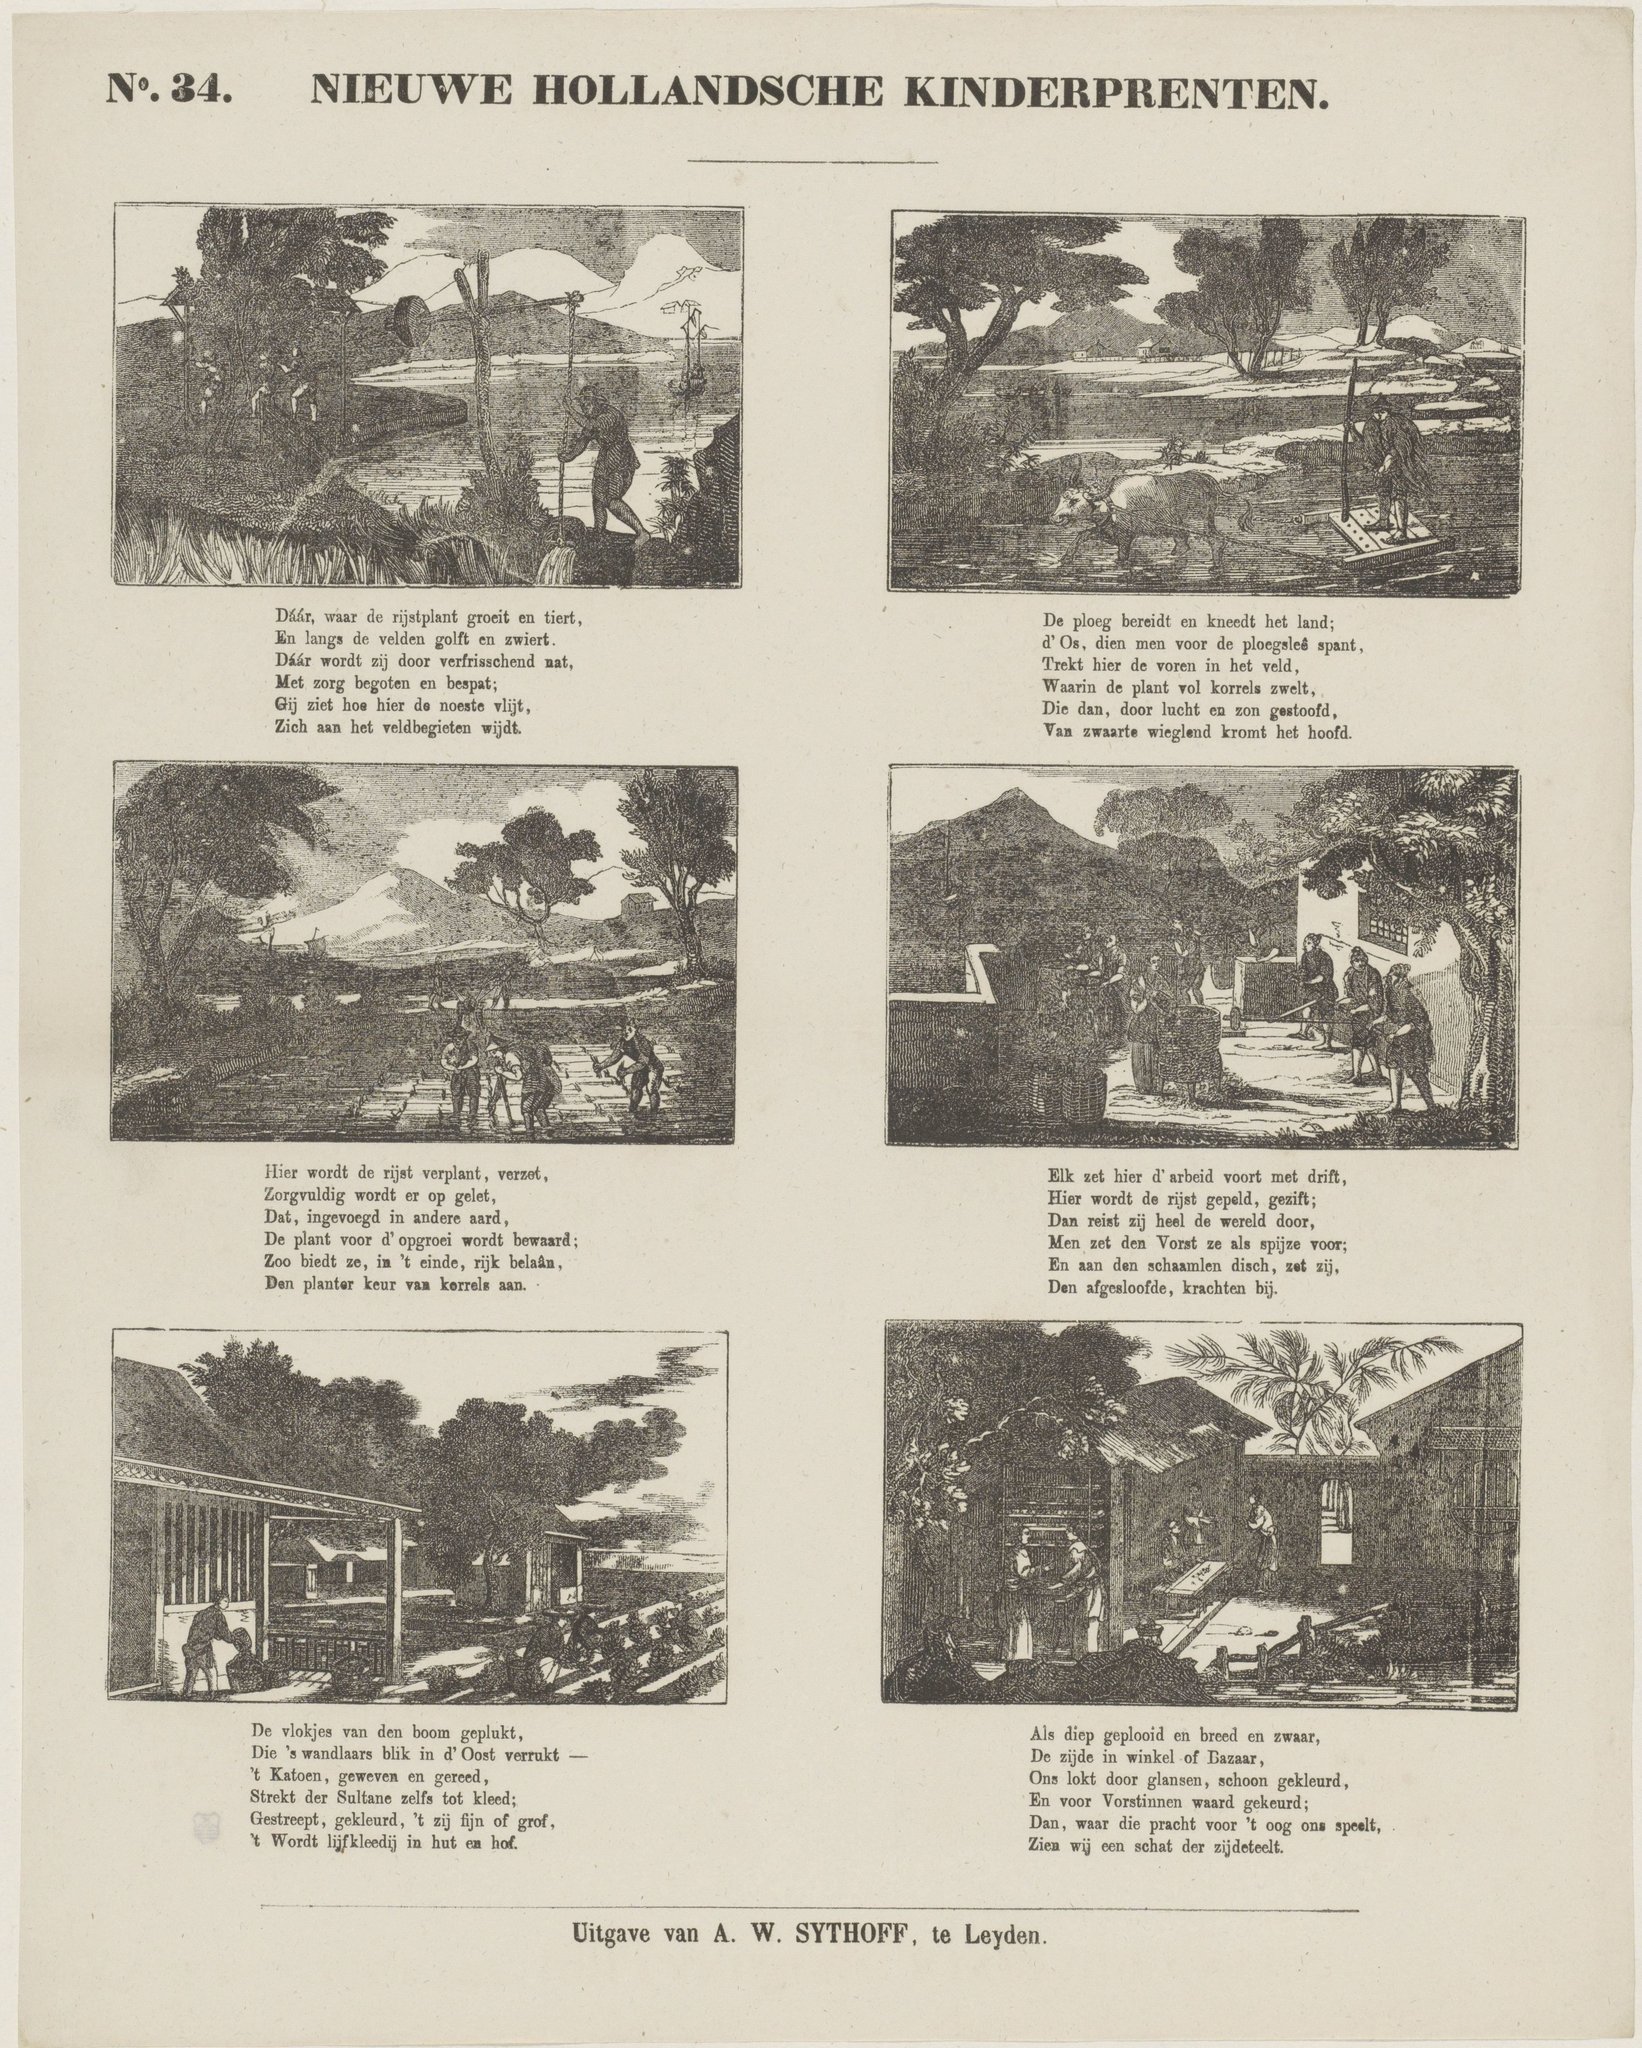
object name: print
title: Nieuwe Hollandsche kinderprenten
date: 1861-1929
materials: paper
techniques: letterpress printing, engraving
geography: leiden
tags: cereal, grain, corn (grass with grains, grown for food, e.g.: wheat, rice, rye, oats, maize, buckwheat, millet) (+ labourers ~ crafts, industries, agriculture), sawahs, rice paddies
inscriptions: collector's mark: Lugt 2760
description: Blad met 6 voorstellingen van de rijstproductie in Azië. Onder elke voorstelling een zesregelig vers. Genummerd linksboven: No. 34.